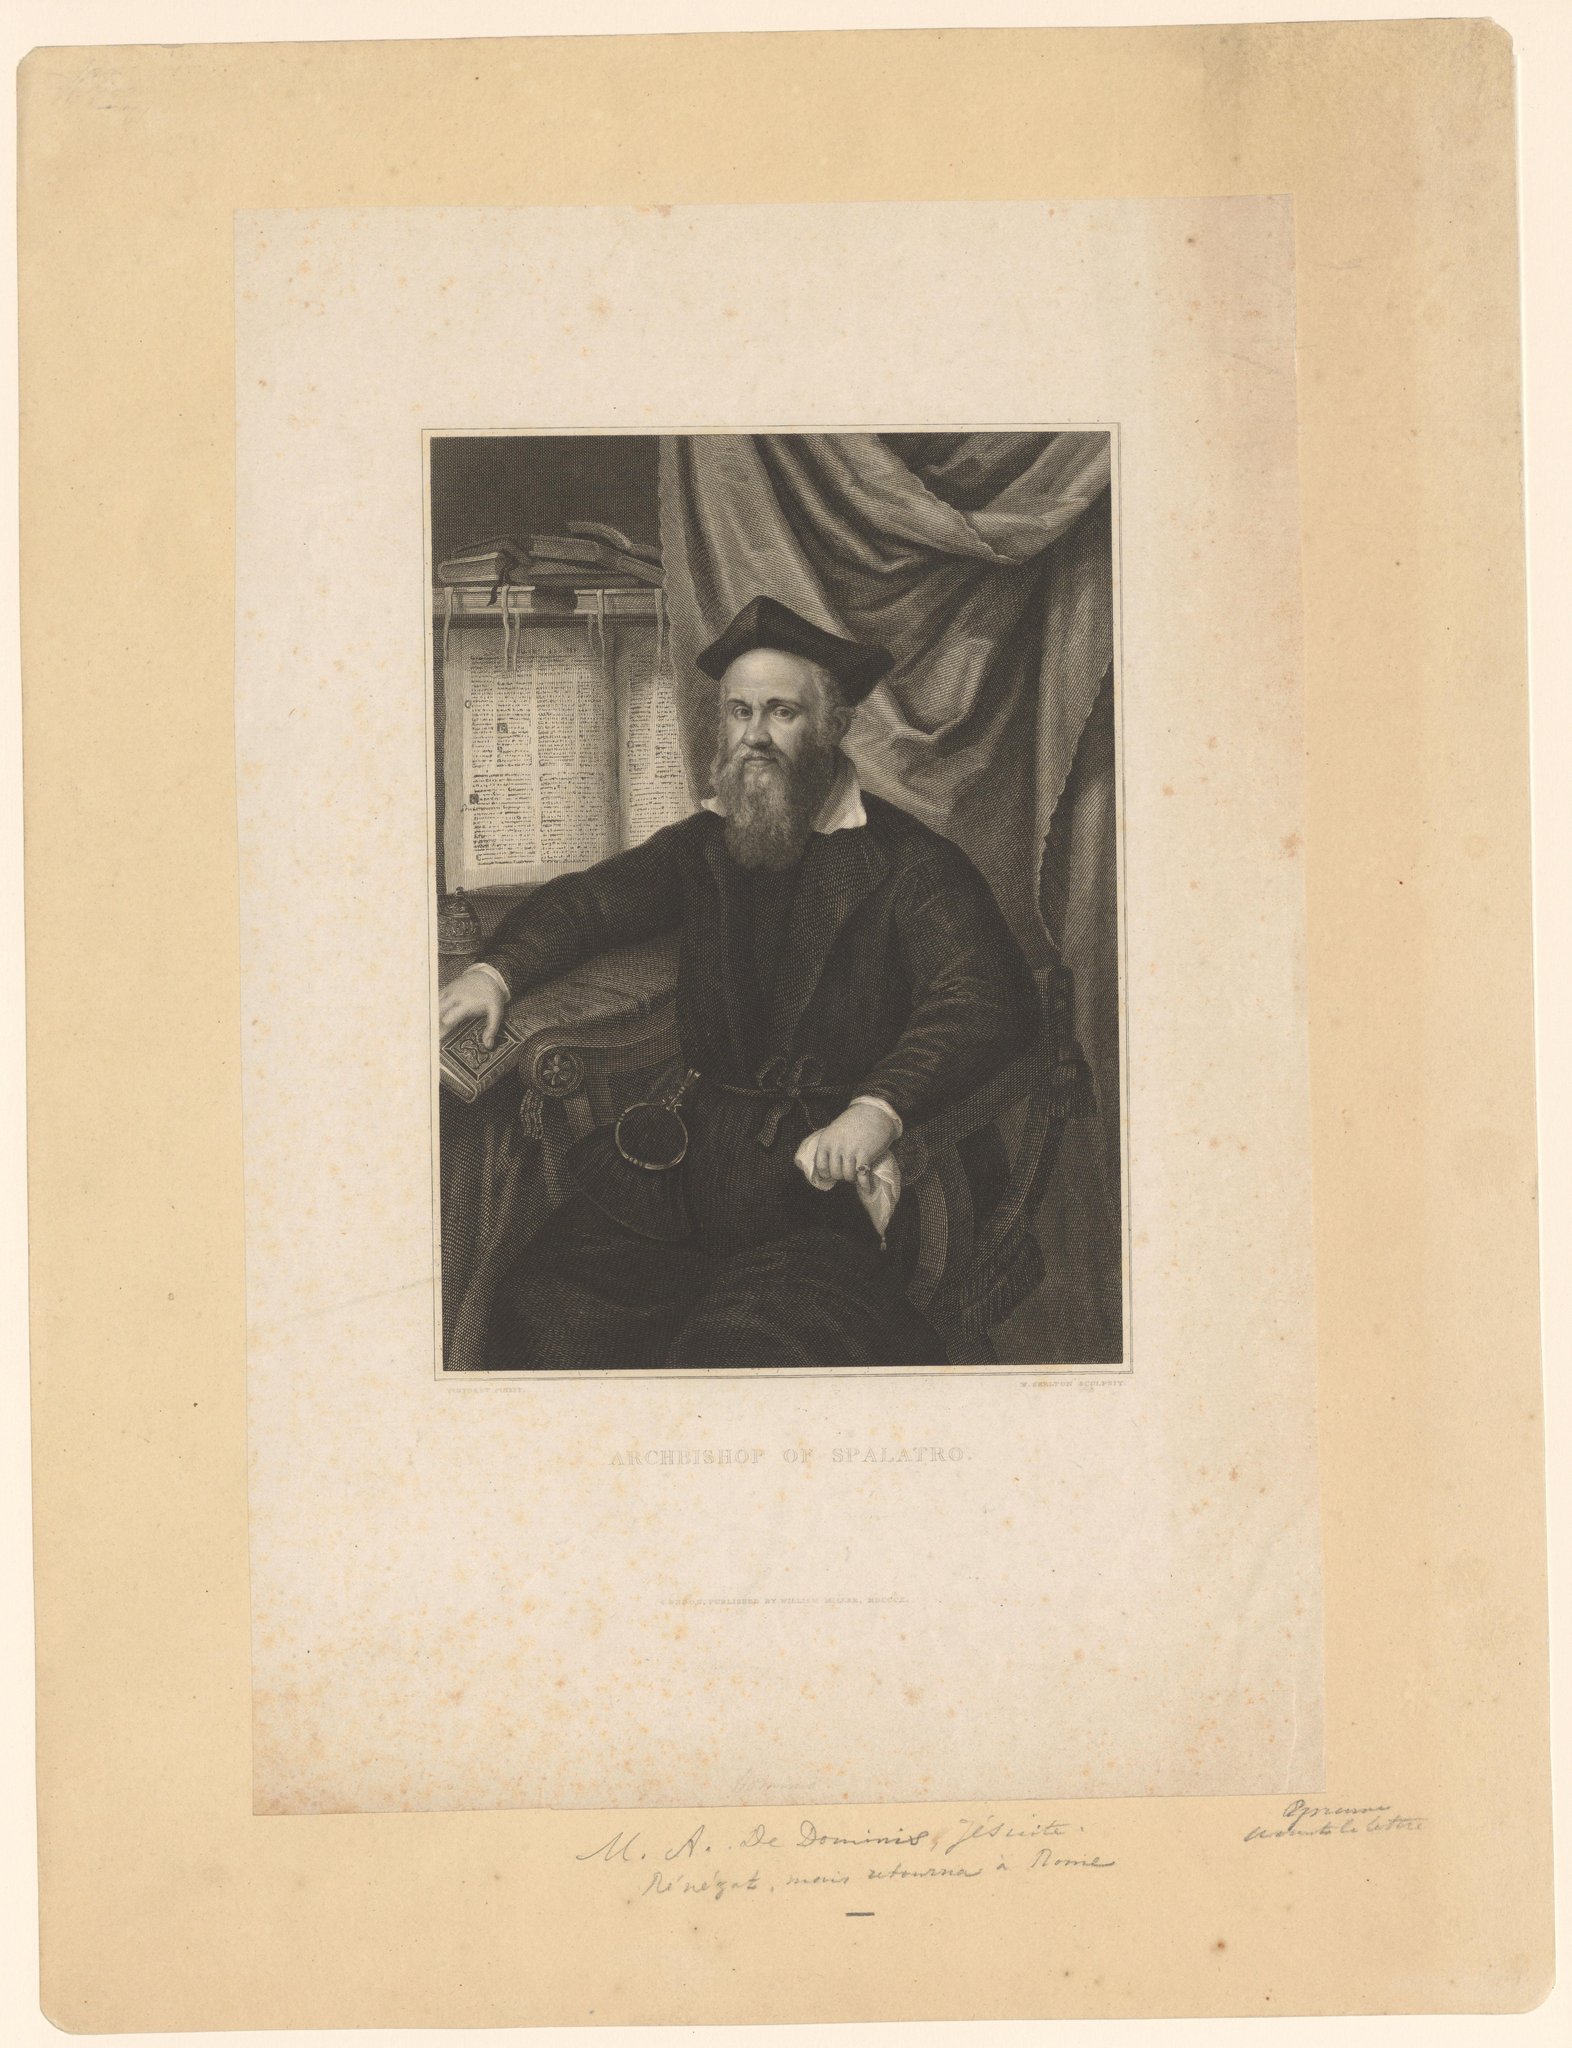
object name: print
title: Portret van Marcus Antonius de Dominis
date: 1810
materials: paper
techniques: engraving, etching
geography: london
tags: rome, archbishop, bishop, etc. (roman catholic), historical persons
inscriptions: collector's mark: Lugt 2228